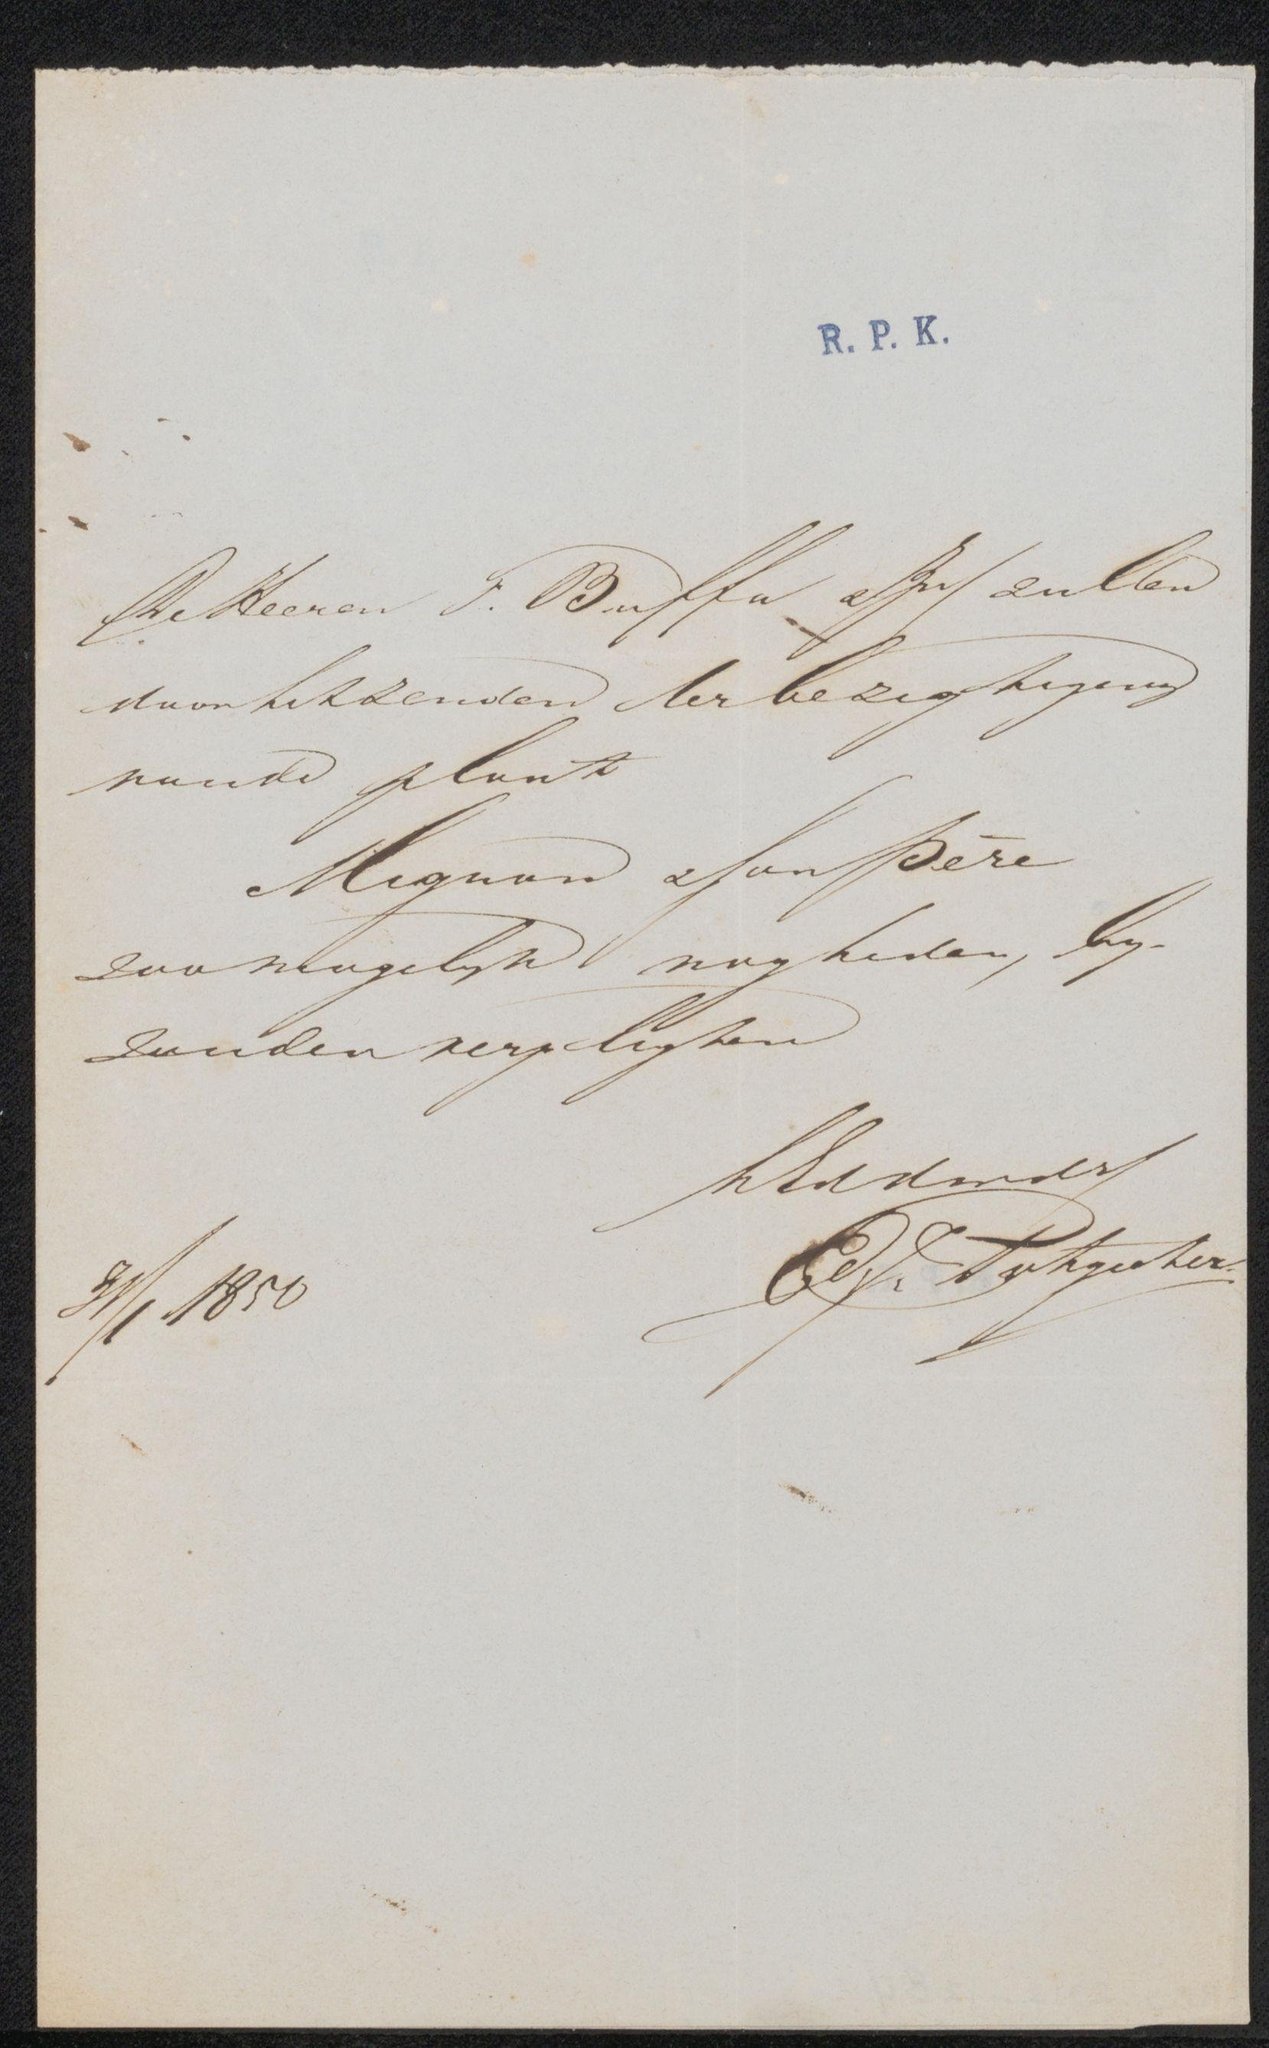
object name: letter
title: Brief aan Frans Buffa en Zonen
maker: everhardus johannes potgieter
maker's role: letterkundige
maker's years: 1808-1875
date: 1850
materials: ink, paper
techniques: pen, writing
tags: publisher, the graphic arts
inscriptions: collector's mark: Lugt 2233